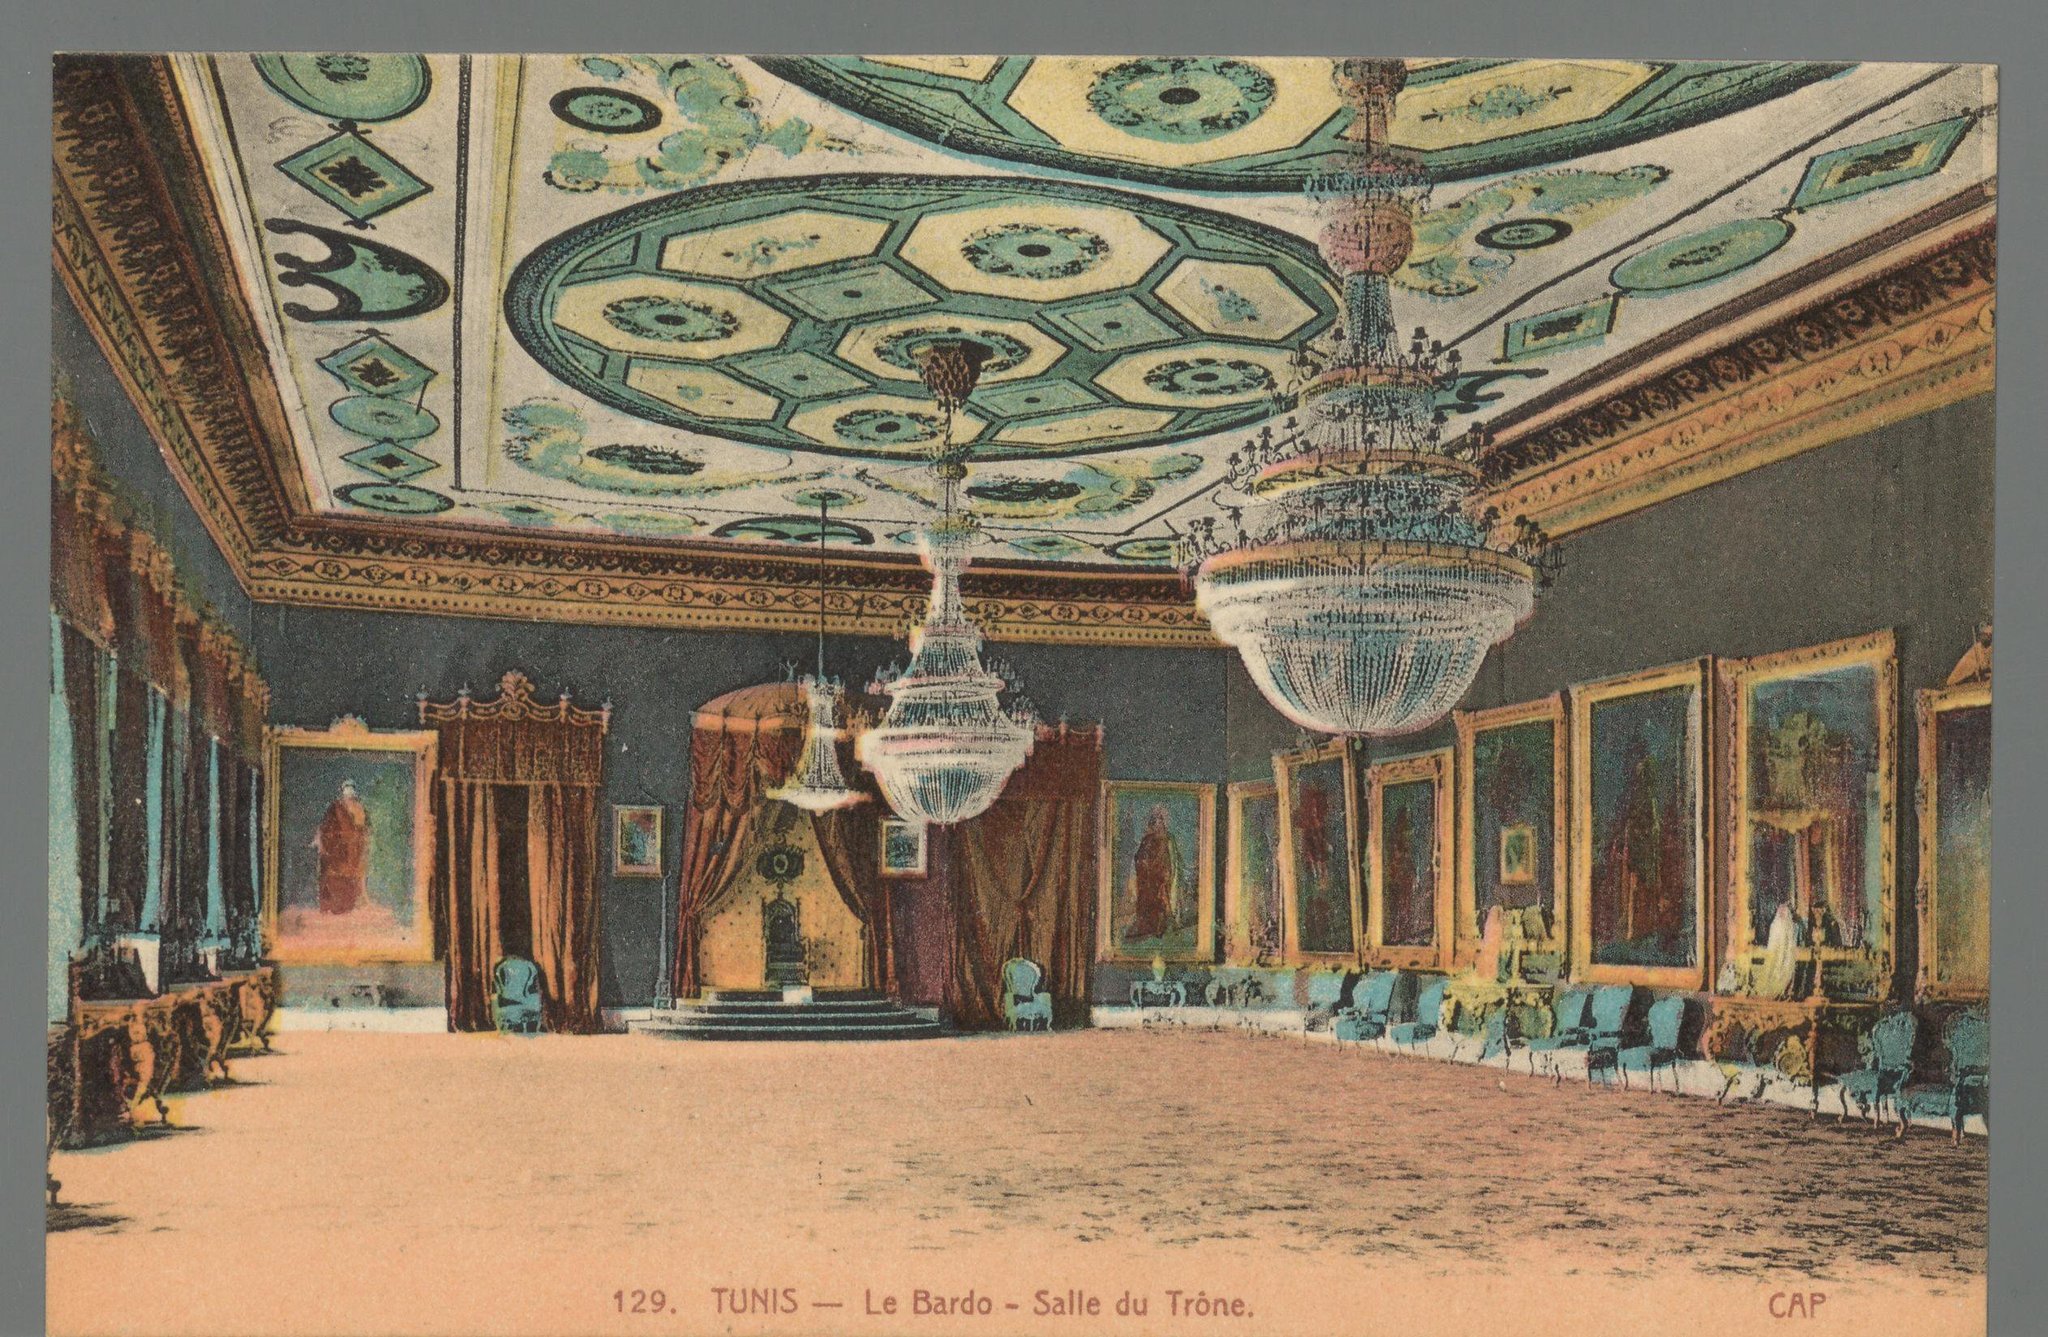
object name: photomechanical print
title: Tunis - Le Bardo - Salle du Trône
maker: Anonymous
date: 1903-1930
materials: cardboard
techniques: photograph, lithograph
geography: straatsburg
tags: interior of the house, permanent exhibition, museum